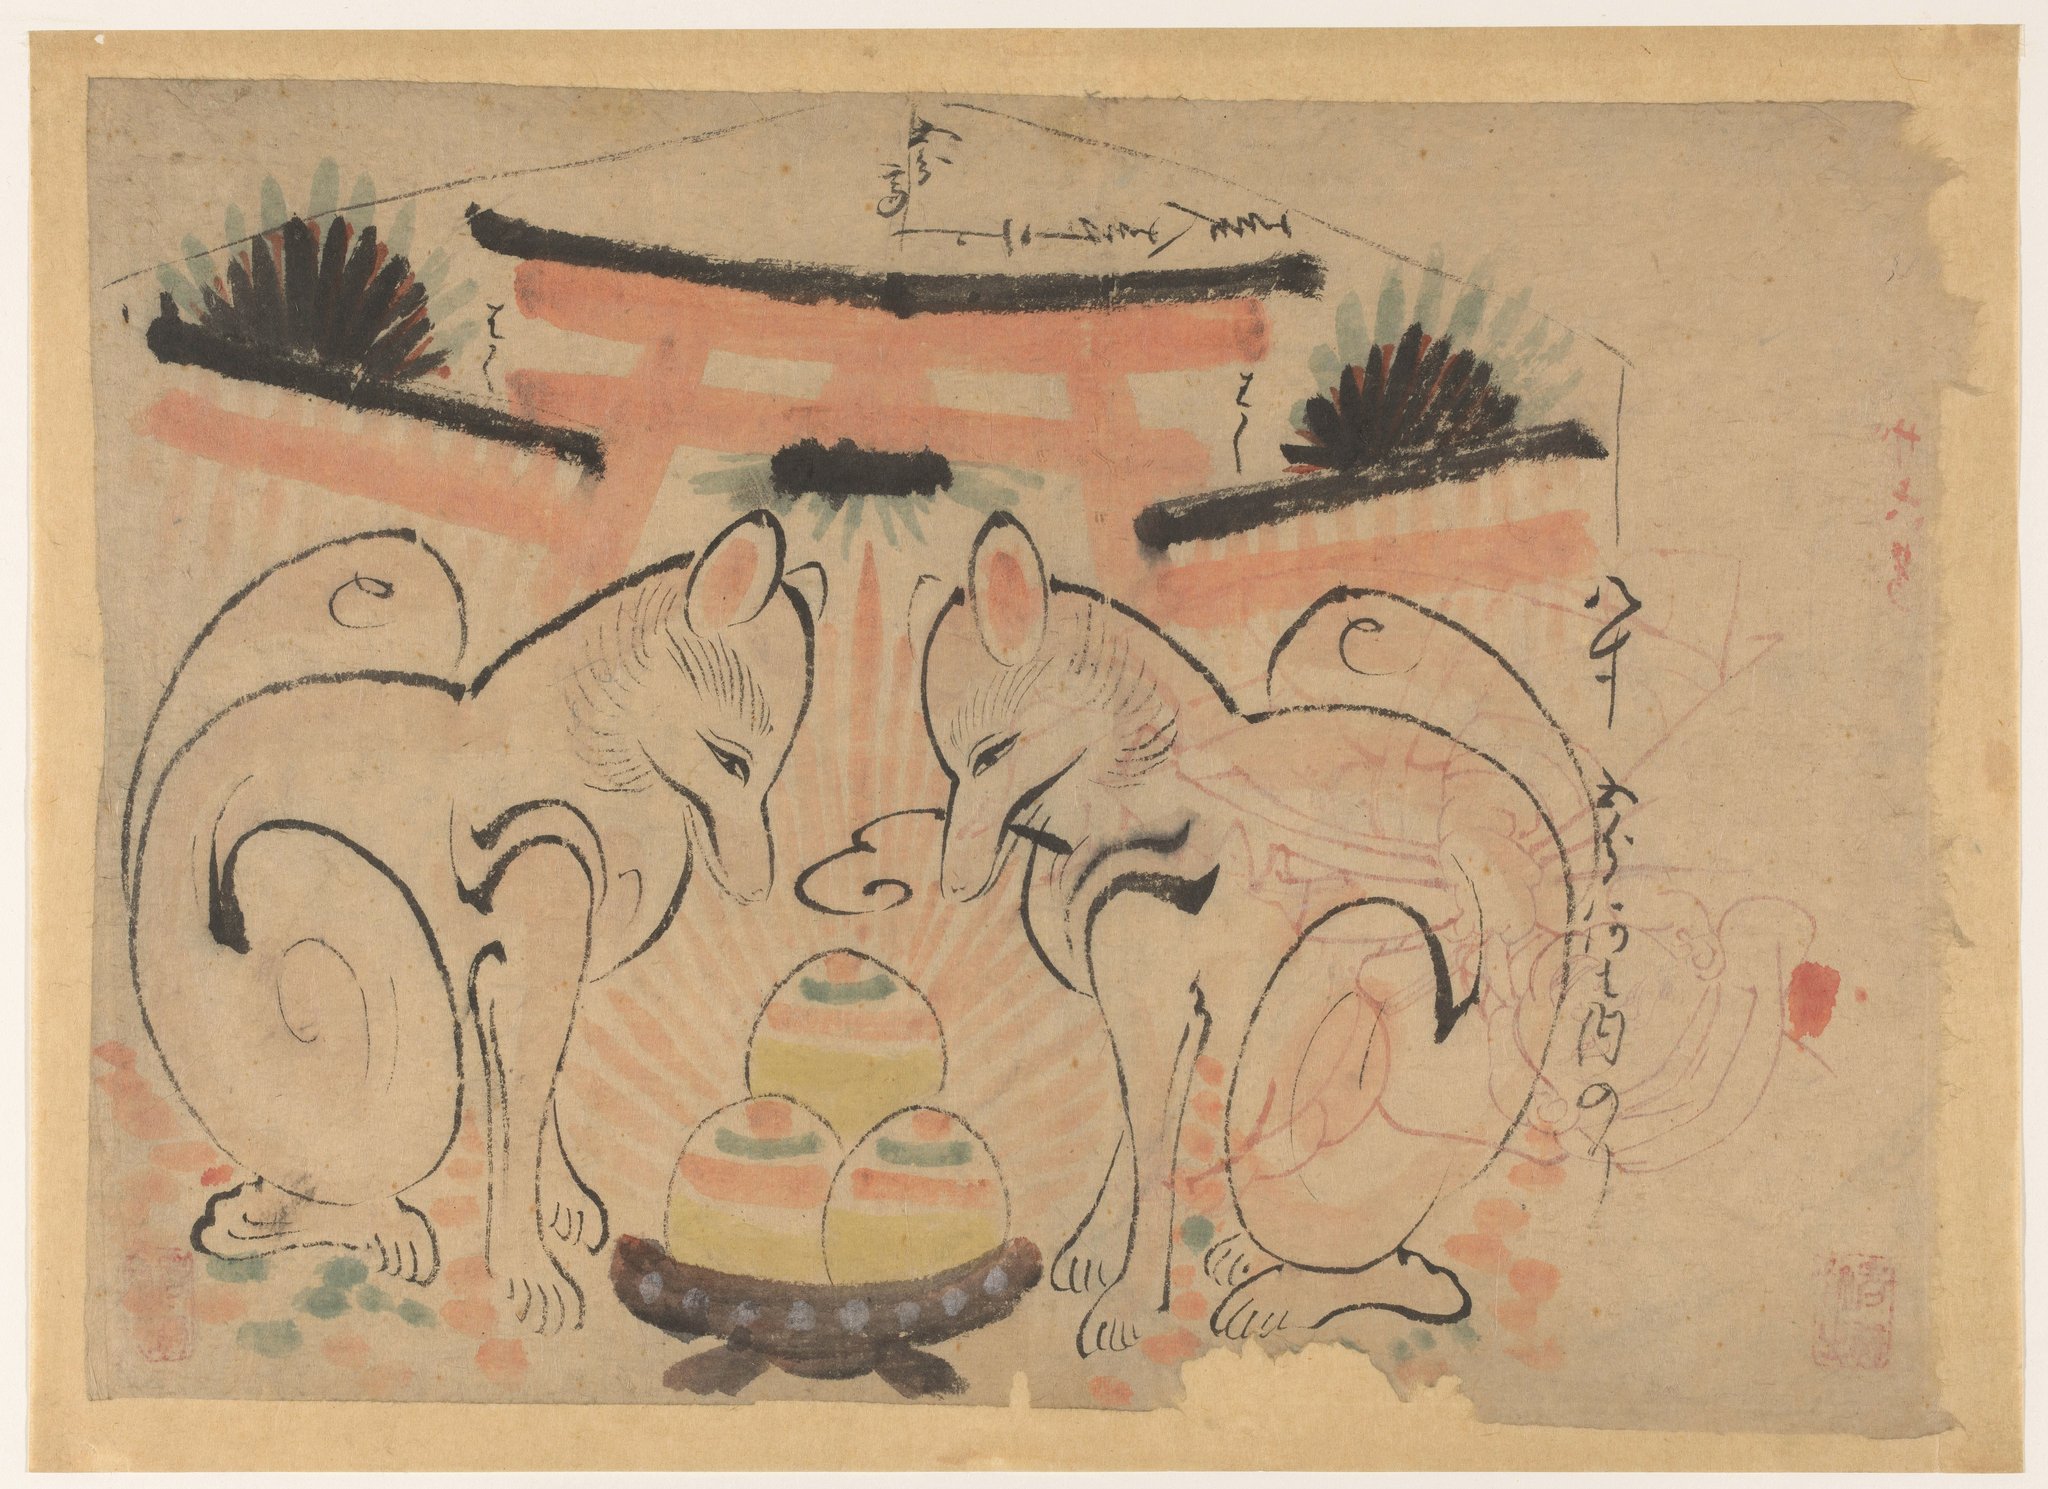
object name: watercolor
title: Twee vossen voor de torri van de Inari Jinja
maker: Anonymous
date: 1800-1900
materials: paper, watercolor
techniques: brush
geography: japan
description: Twee vossen voor de torri van de Inari Jinja, over een schets van Daikoku.